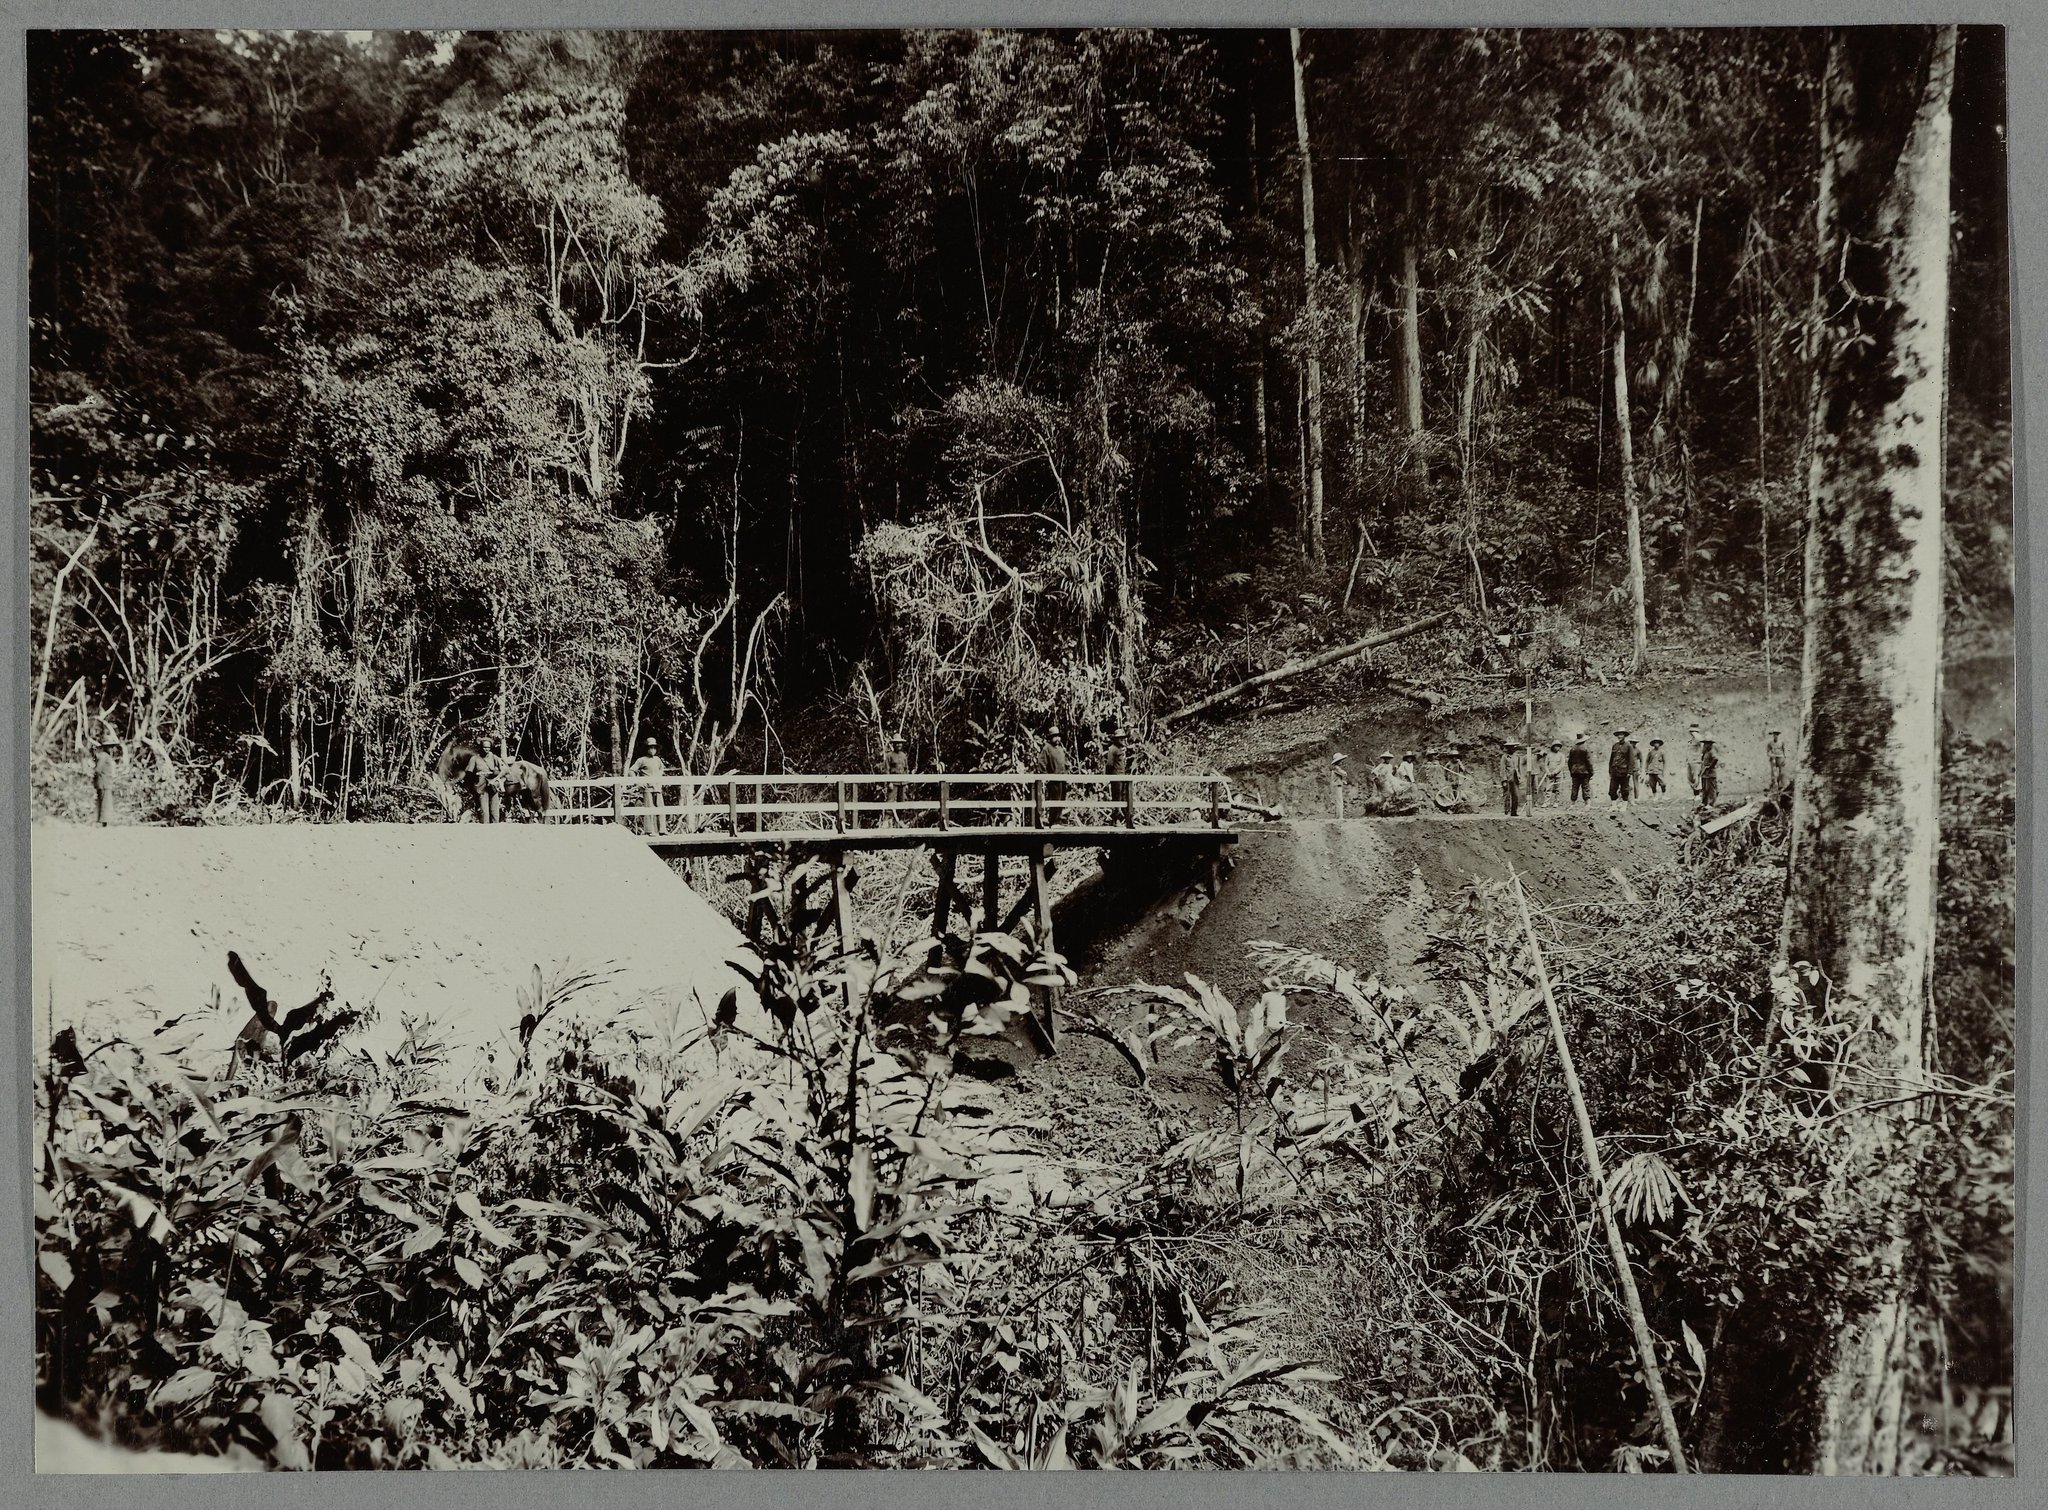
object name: photograph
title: Voltooide houten brug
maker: Anonymous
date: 1903-1913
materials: photographic support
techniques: photography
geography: north sumatra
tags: arnhem, the hague, albertus dominicus laman trip, building activities, traffic by road or path with motor-vehicle, landscapes in tropical and sub-tropical regions, road, path, bridge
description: Na de expedities naar de Gajo- en Alaslanden o.l.v. Van Daalen (eerste tocht in 1901), werd hij in 1903 belast met voorbereiding van permanente vestiging van Nederlands gezag. Aanleg van een weg van de Noordkust naar het binnenland was hierbij van groot belang. Deze zgn. Gajoweg werd aangelegd tussen 1903 en 1914, van Bireuen aan de kust naar Takinguen aan het bergmeer Danau Lauttawar, totale lente 104 km.